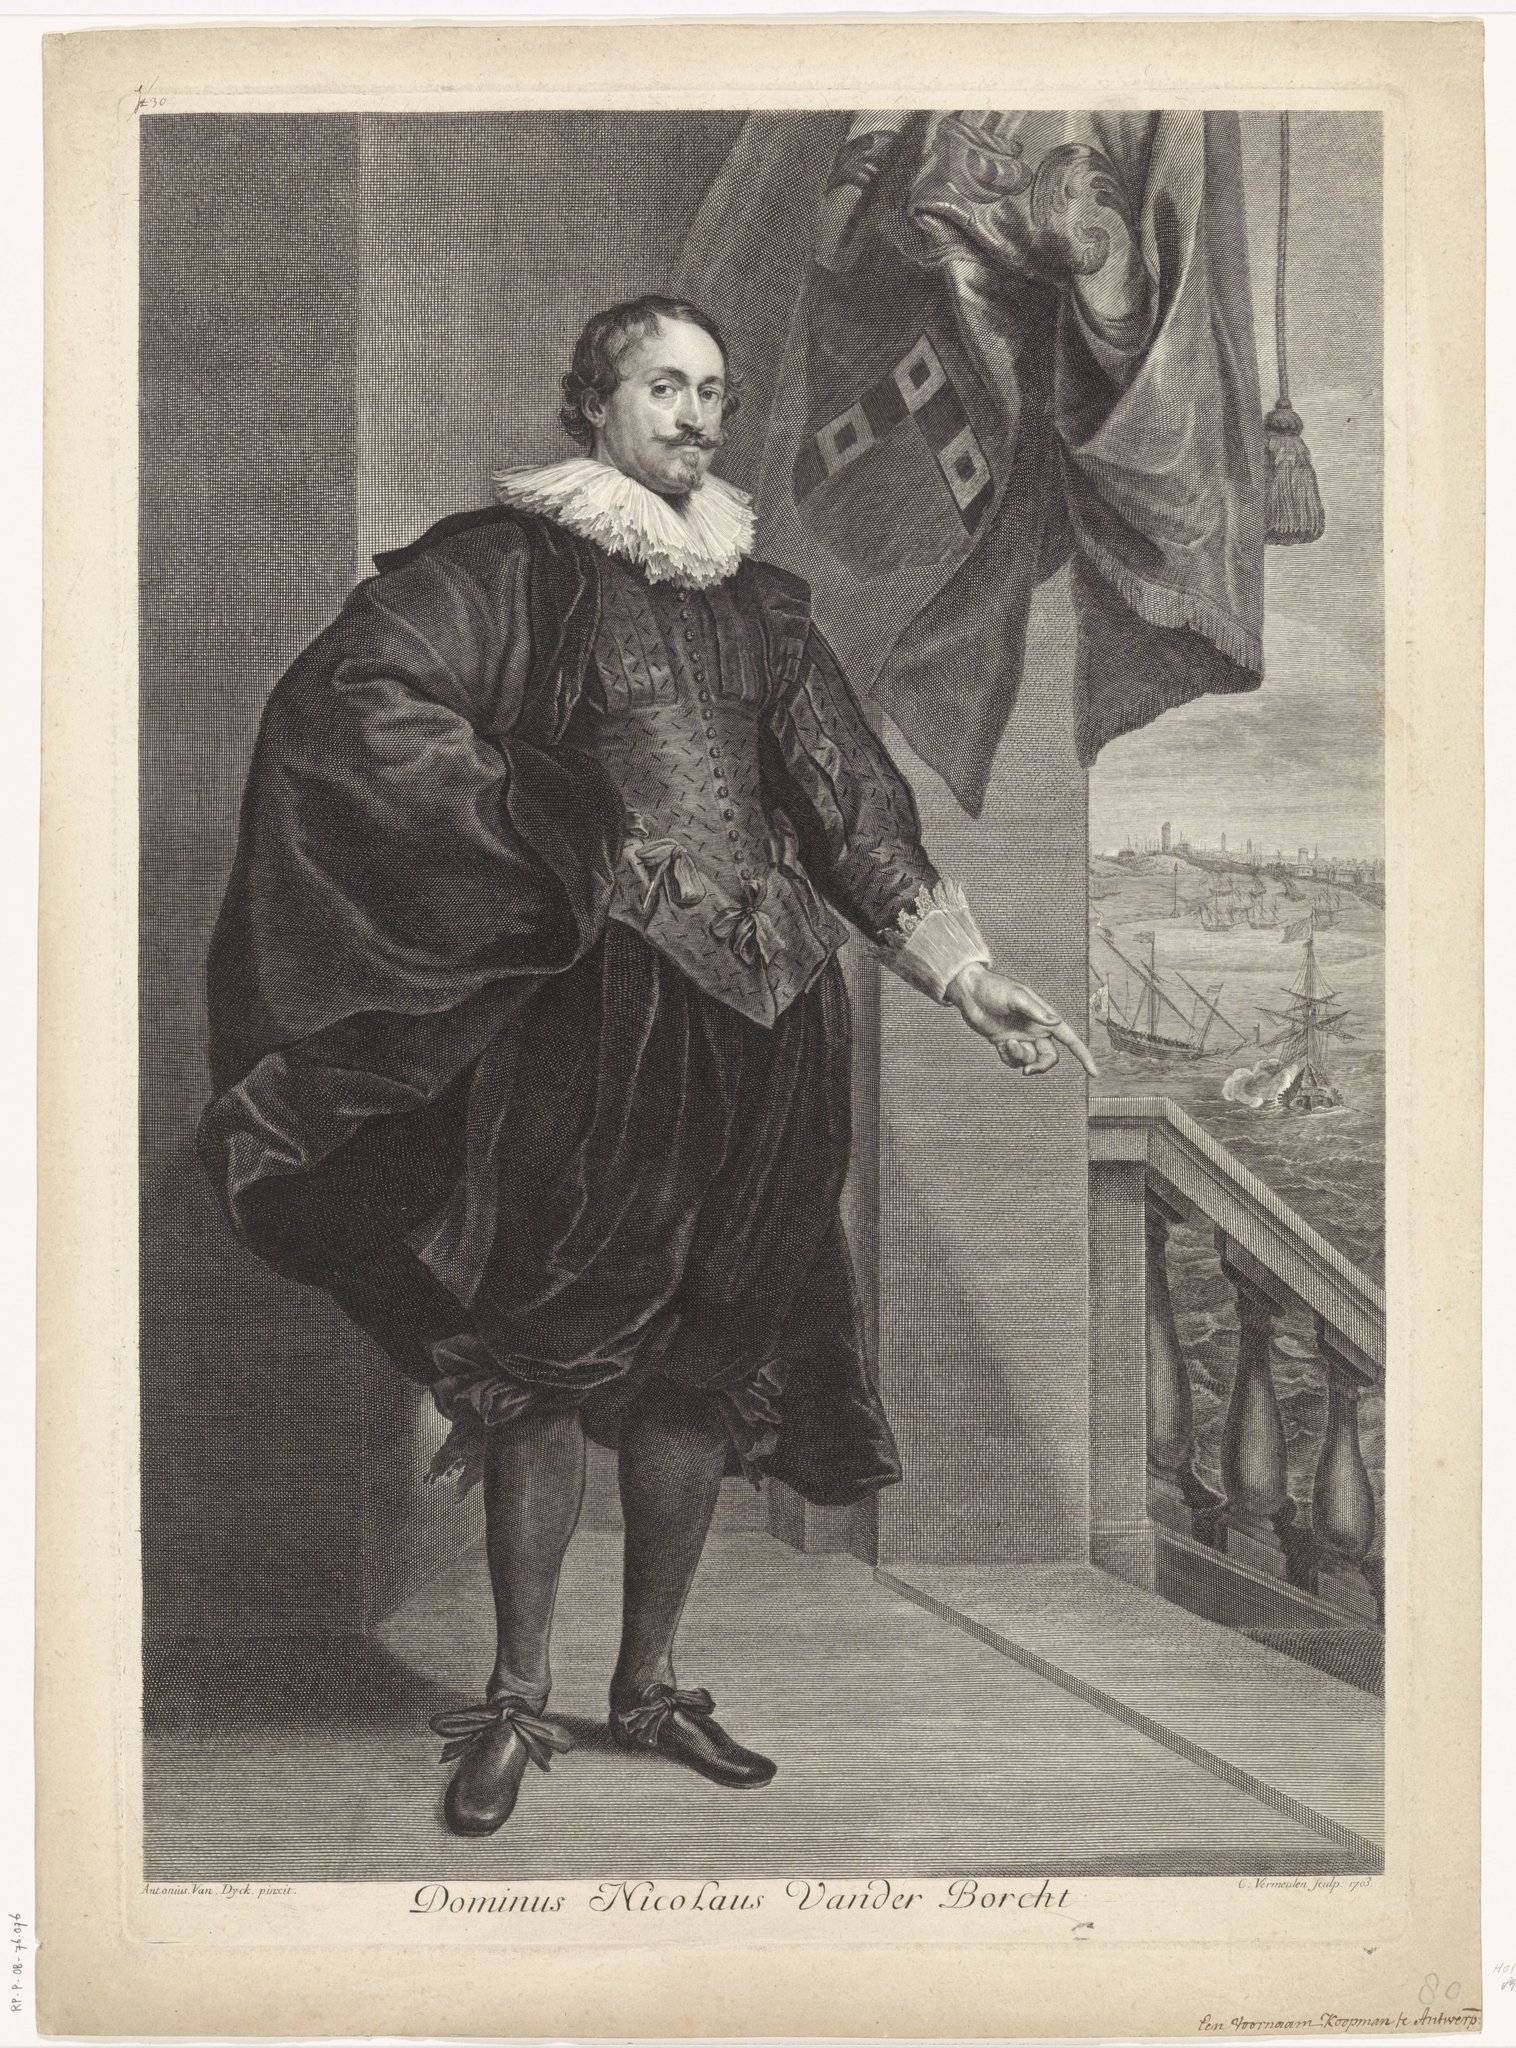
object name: print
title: Portret van een edelman, mogelijk Adriaan van der Borcht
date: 1703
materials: paper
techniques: engraving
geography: antwerp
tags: schipper, adriaan van der borcht, nicolaes van der borcht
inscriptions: inscription: ‘Eeen Voornaam Koopman te Antwerpen’, collector's mark: Lugt 2228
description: Over de identiteit van de geportretteerde ontstond al vroeg verwarring. Op dit portret uit 1703 wordt hij aangeduid als Nicolaes van der Borcht, maar vrijwel zeker gaat het om zijn broer, Adriaan van der Borcht. Zie voor een toelichting de catalogusentry bij SK-A-101.